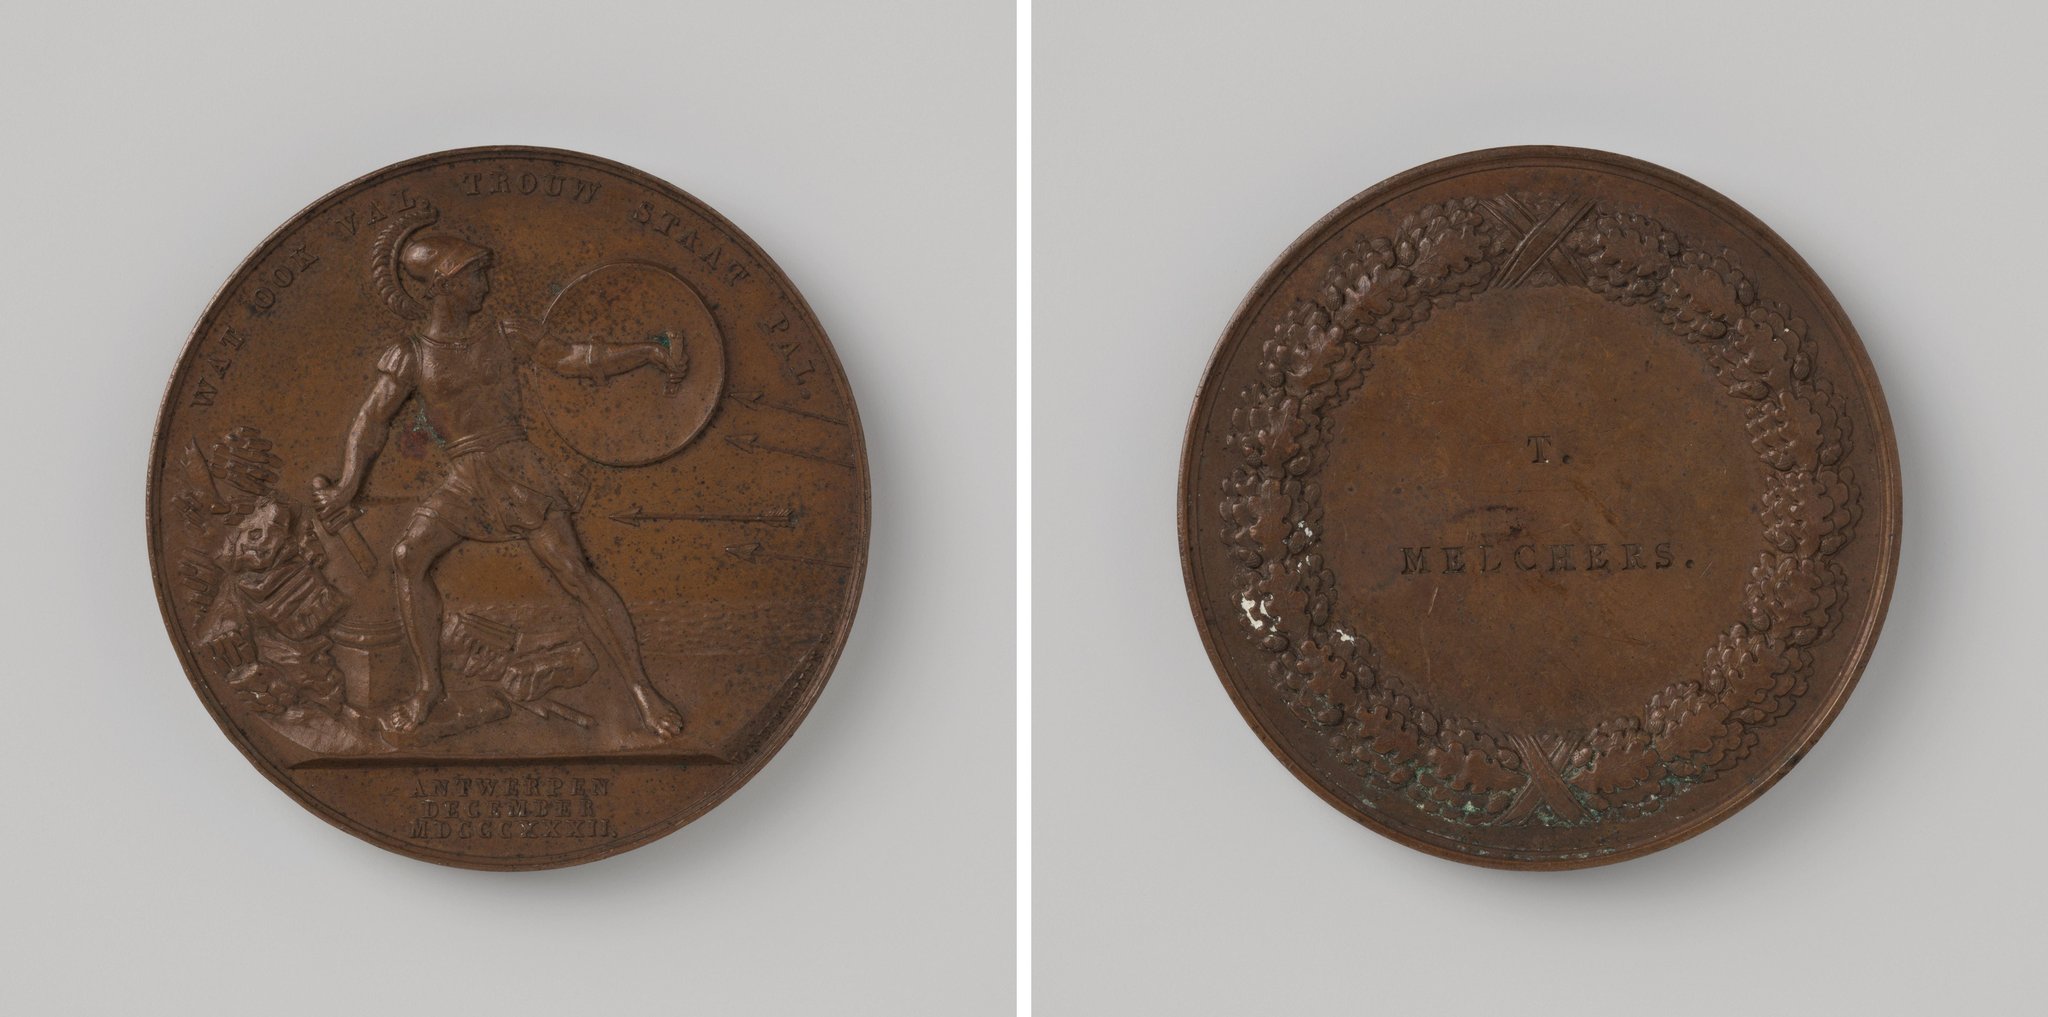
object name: history medal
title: Beloningspenning voor de verdedigers van de Citadel van Antwerpen 1832, op naam van T. Melchers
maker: david van der kellen (1804-1879)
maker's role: die cutter, draughtsman, print maker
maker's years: 1804-1879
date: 1832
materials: bronze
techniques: printing, striking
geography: utrecht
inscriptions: inscription: ‘T. / Melchers.’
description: Bronzen penning, op de voorzijde een soldaat, in antieke kleding met schild en gebroken zwaard, naast puinhopen aan een rivier, weert vijandelijke pijlen af, met omschrift en afsnedetekst, op de keerzijde een inscriptieruimte binnen een zware eikenkrans. Met ingestempelde naam.